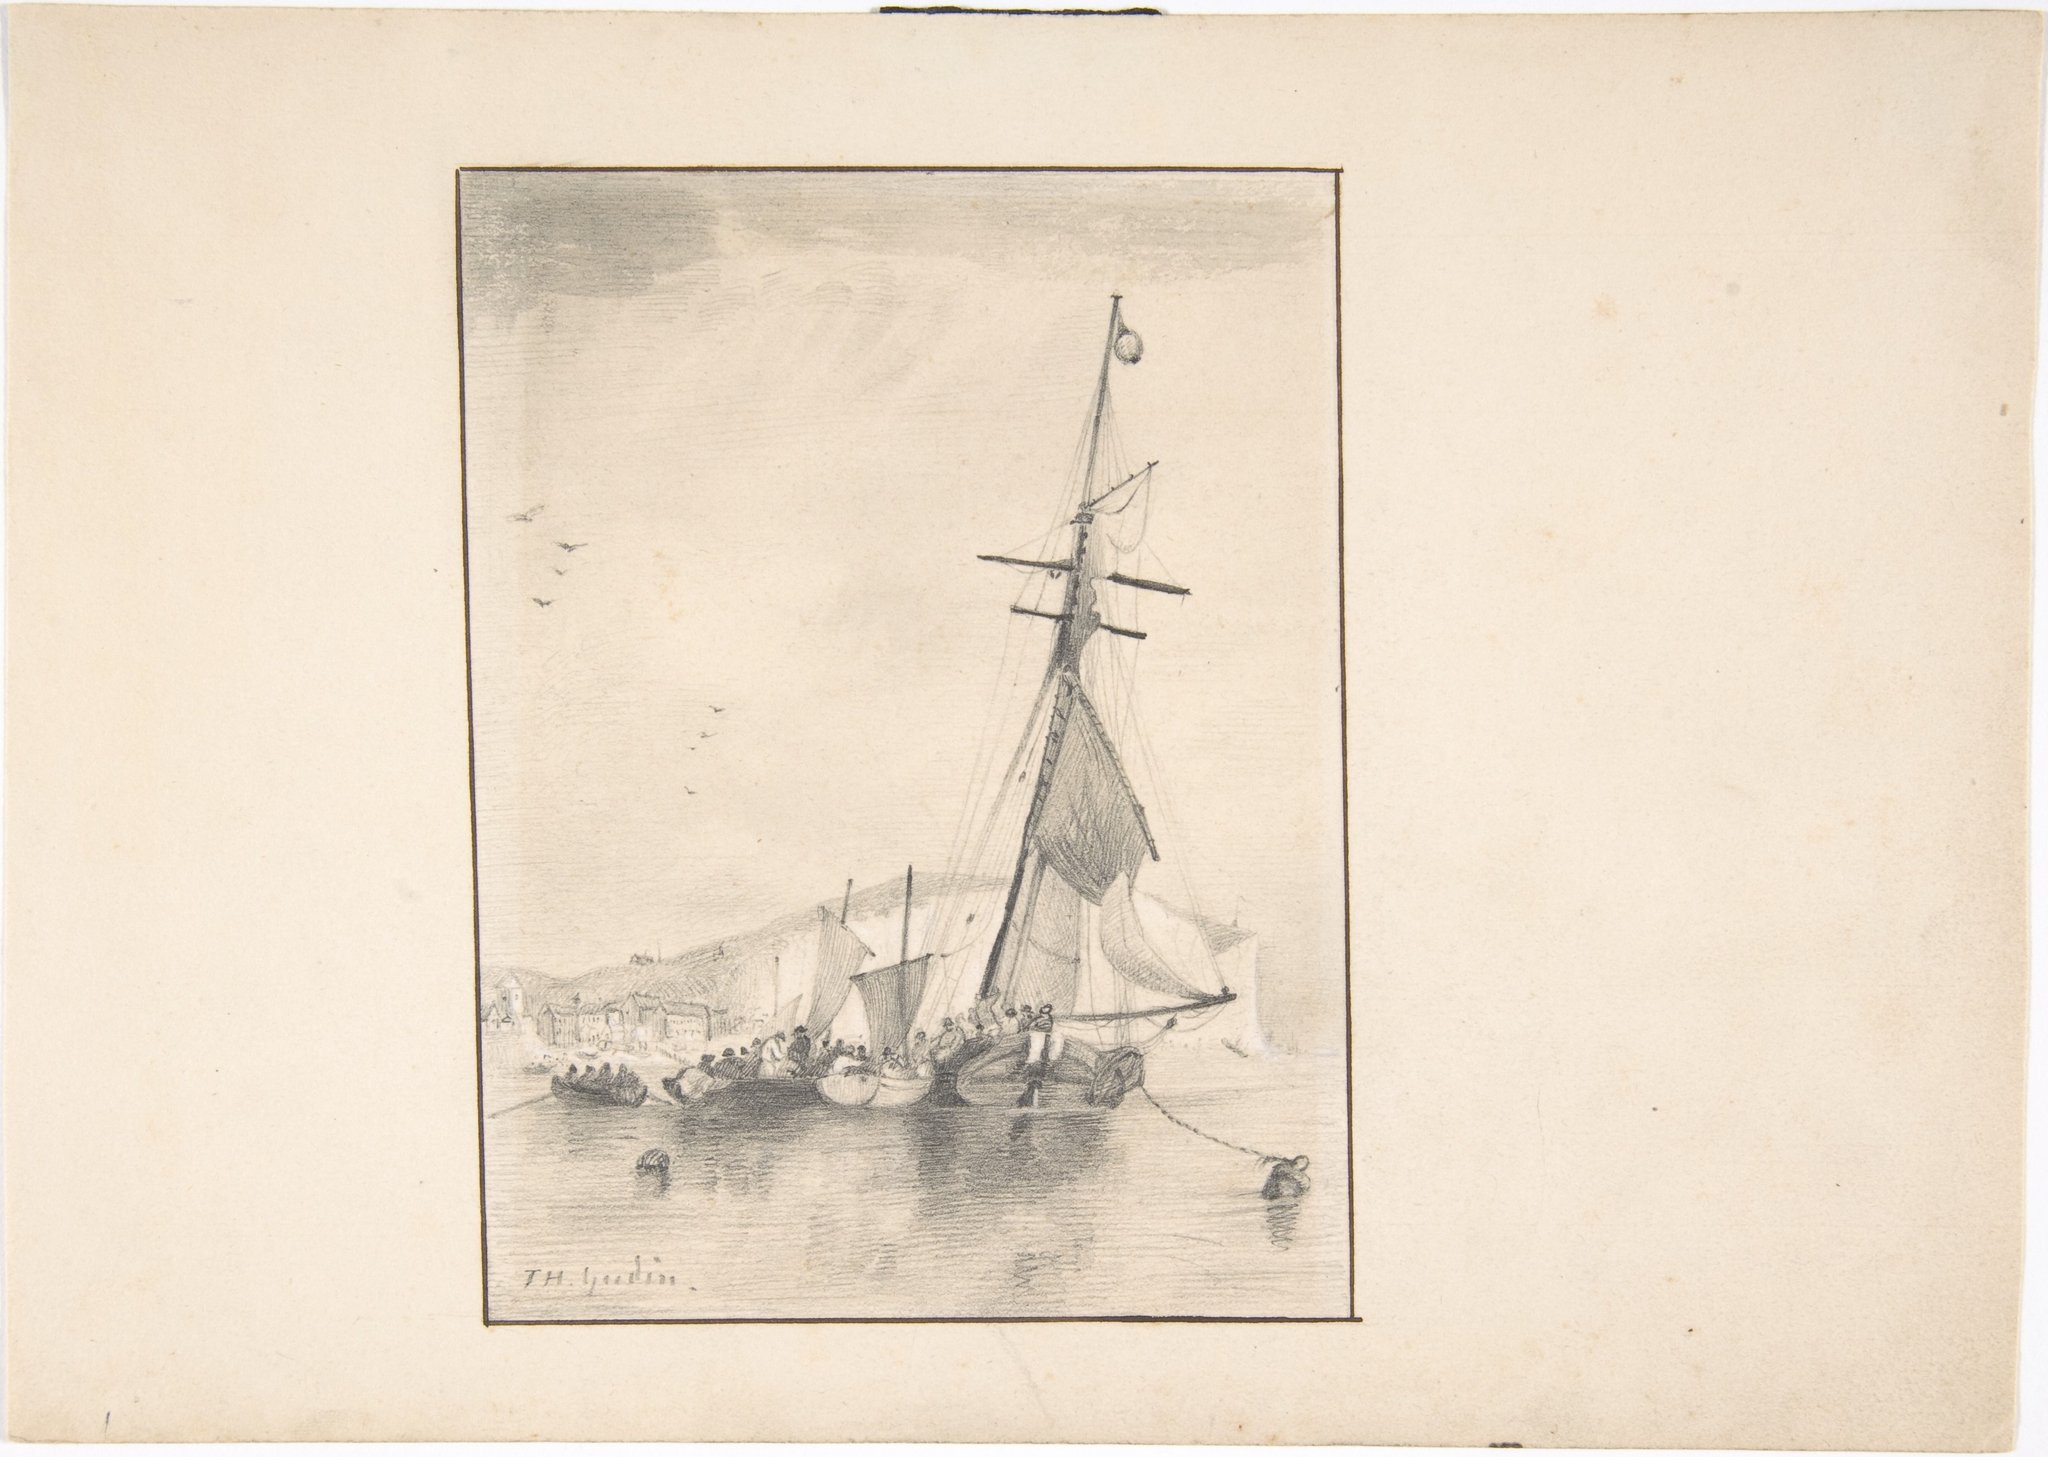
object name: drawing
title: Boats Moored Near Cliffs of Dover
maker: t. h. yudin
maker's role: artist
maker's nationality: british (?)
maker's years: 19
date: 1801-1900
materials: graphite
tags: boats